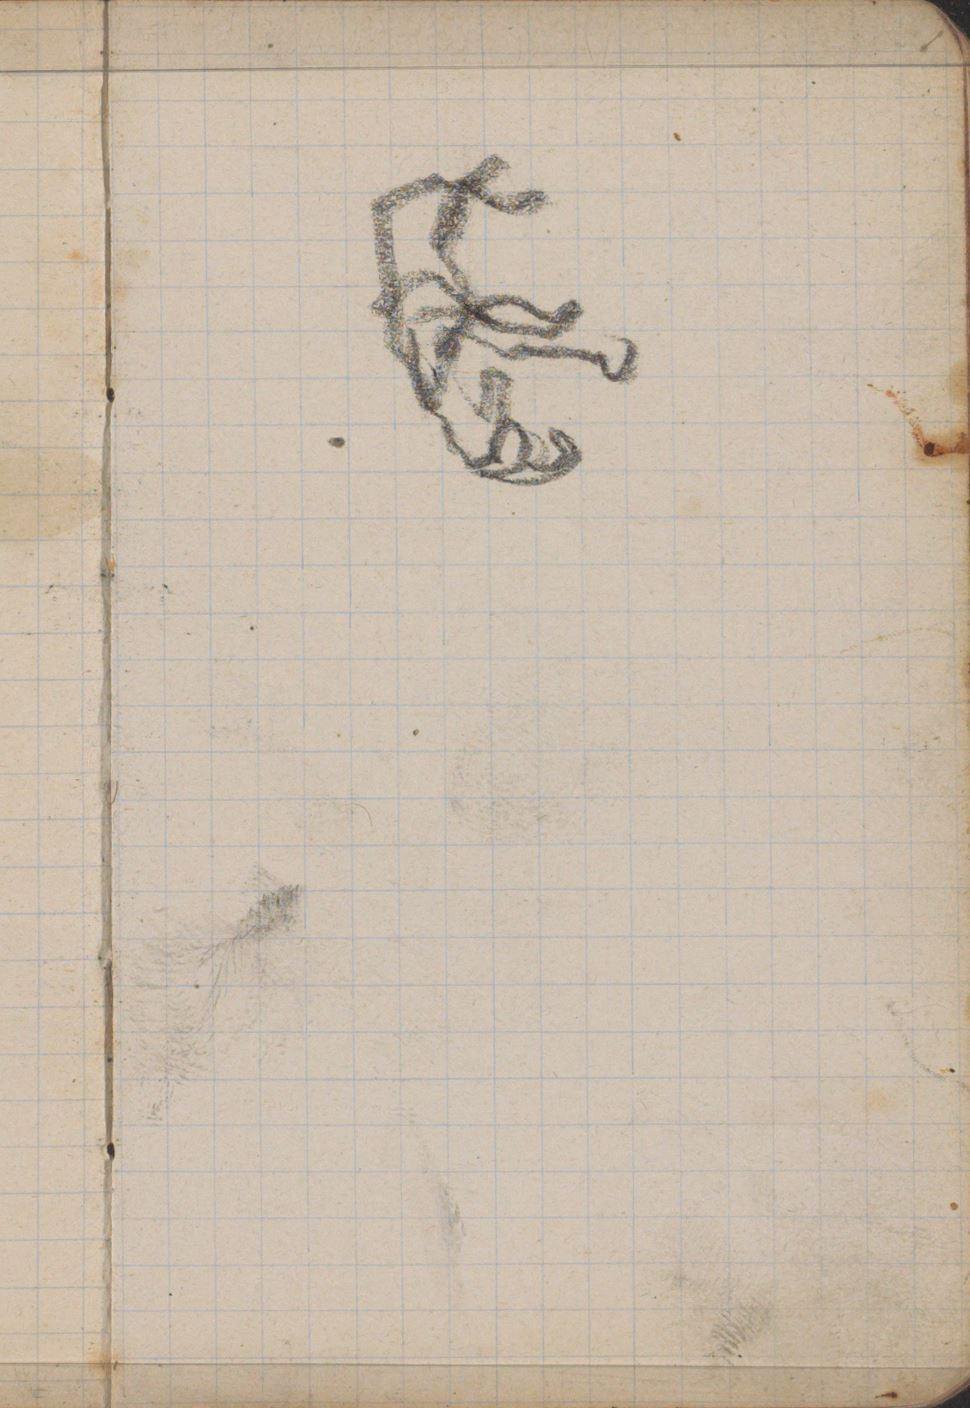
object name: sketchbook leaf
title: Studie, mogelijk van een dier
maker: george hendrik breitner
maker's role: draughtsman, painter, print maker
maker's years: 1857-1923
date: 1893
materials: chalk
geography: amsterdam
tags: animals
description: Pagina 22 uit een schetsboek met 30 bladen vervaardigd in Amsterdam.